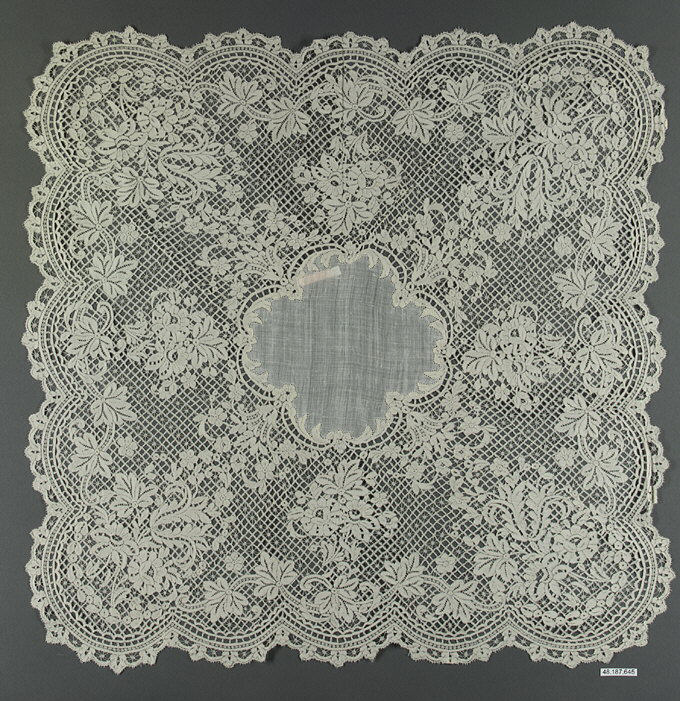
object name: handkerchief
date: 1867-1900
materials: linen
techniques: lace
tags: flowers